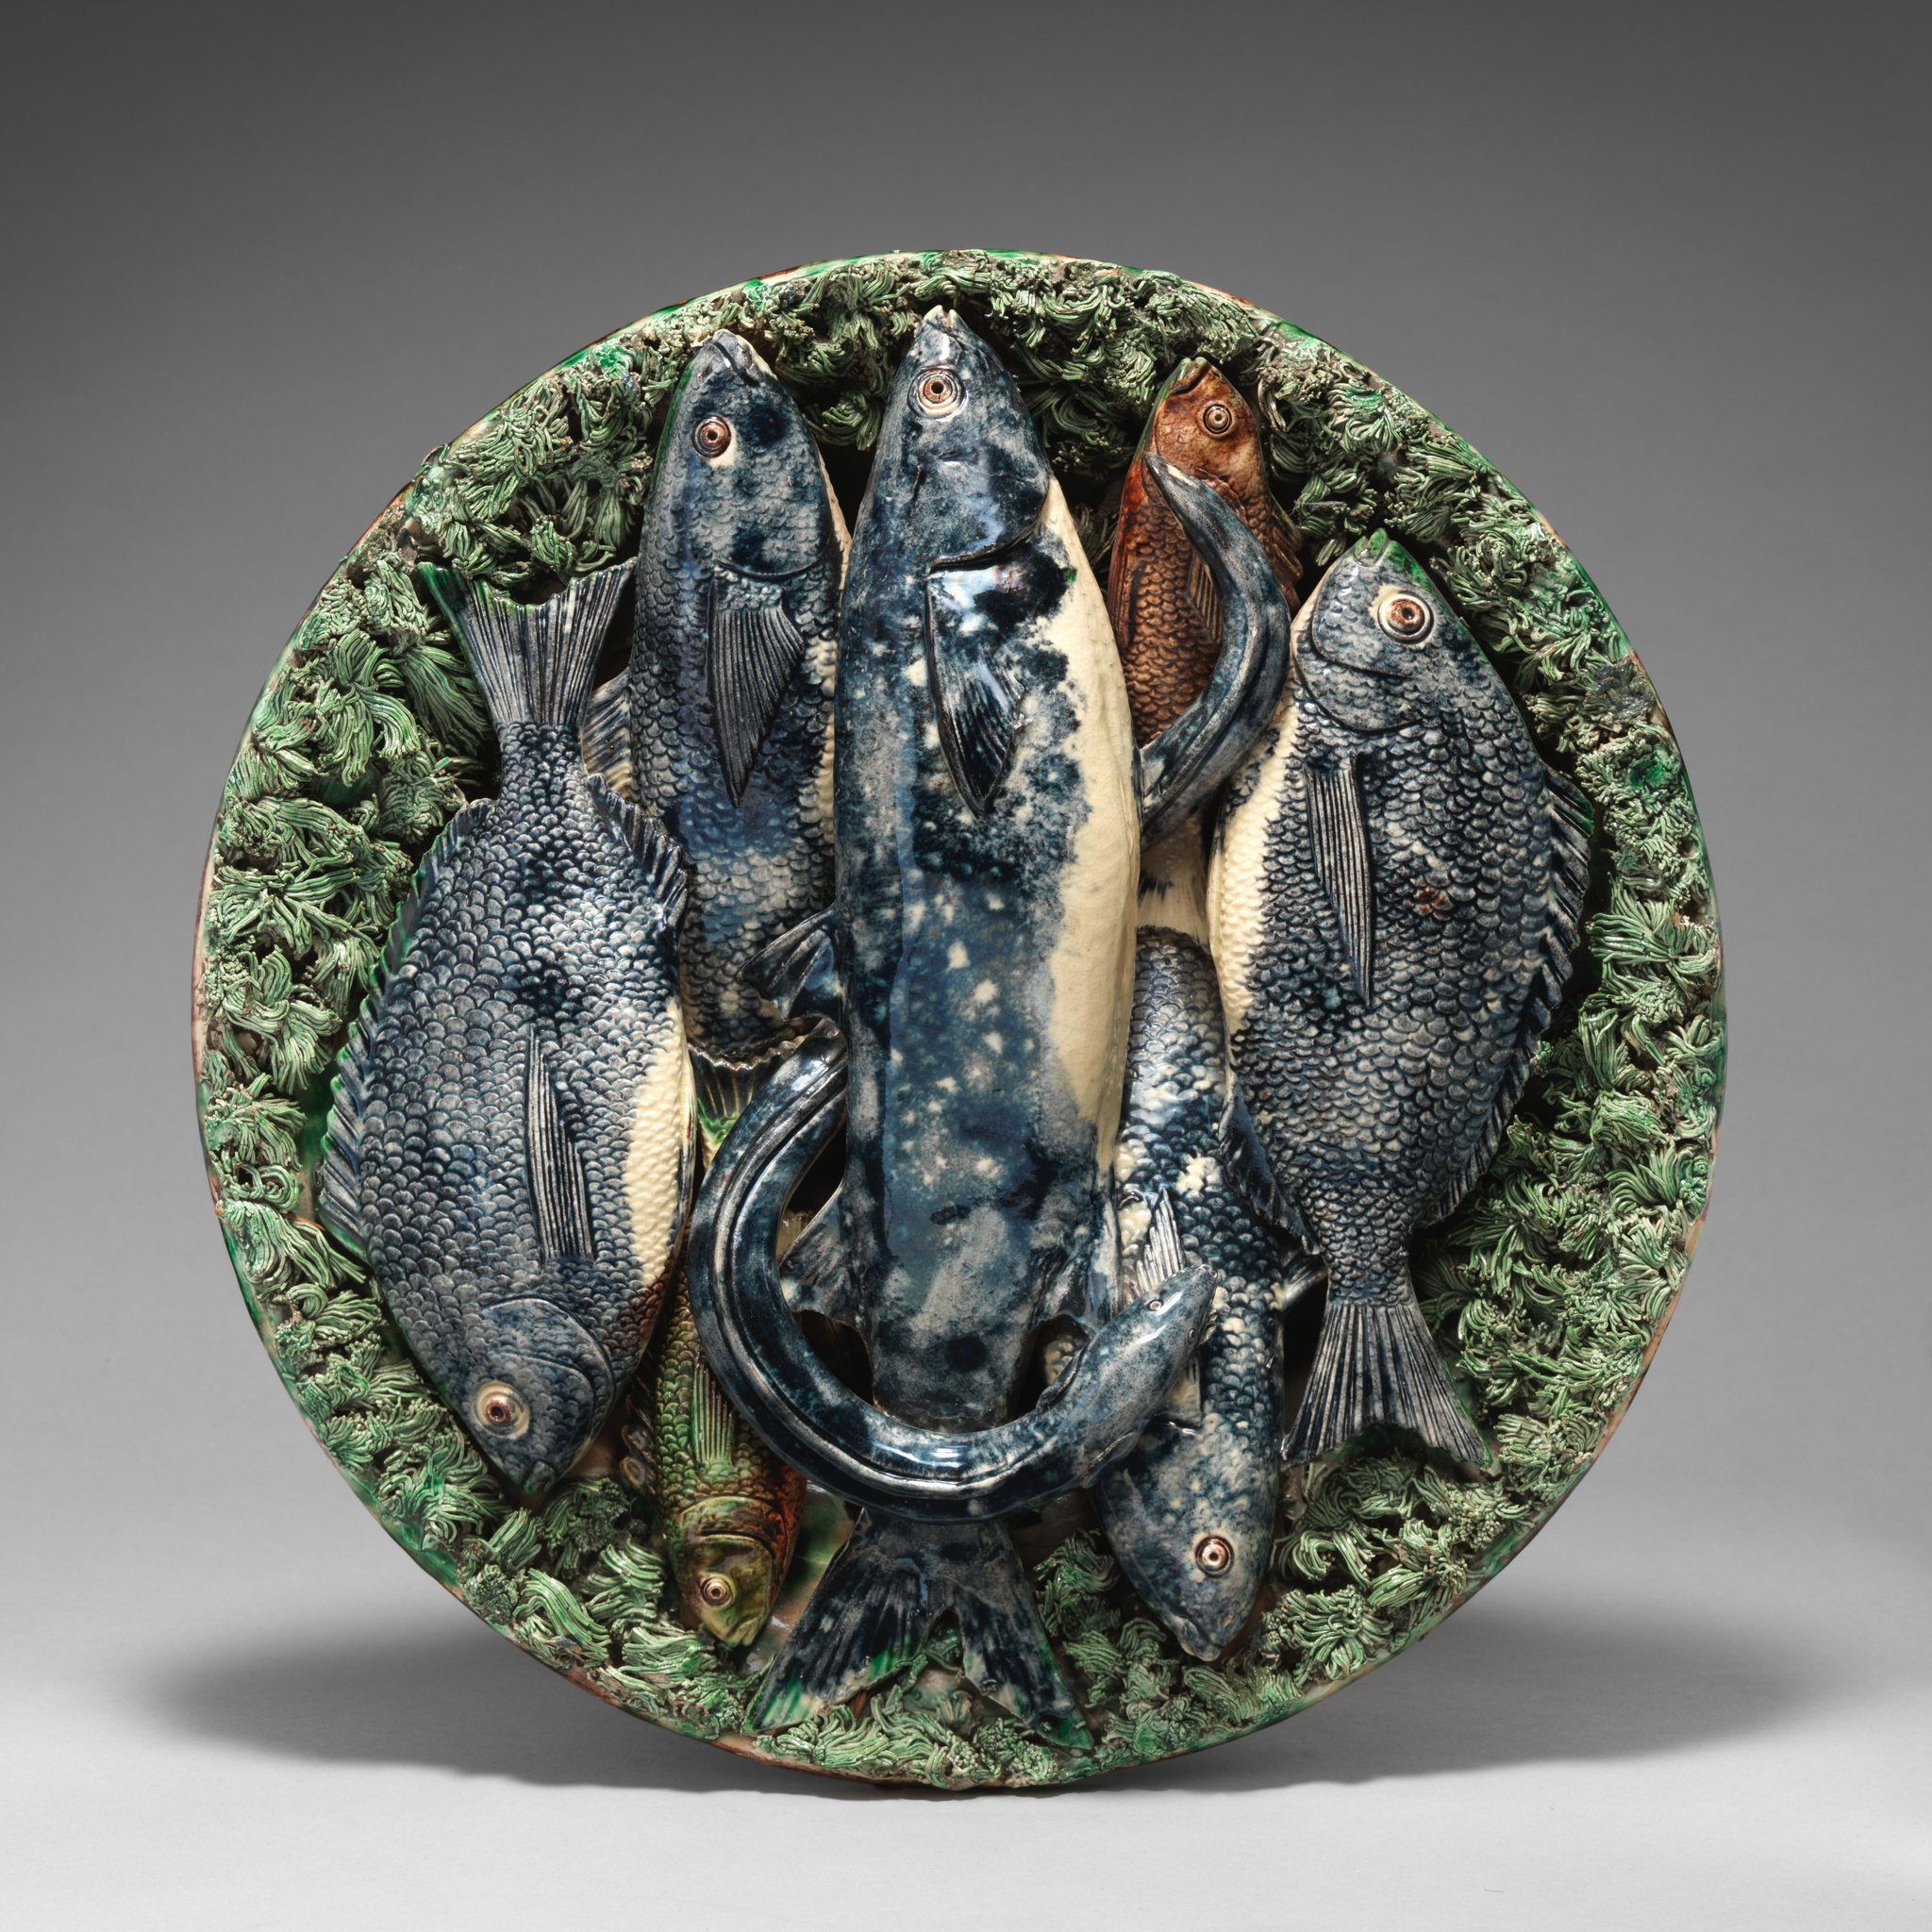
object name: plate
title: Round dish with moss and fish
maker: josé francisco de sousa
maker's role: maker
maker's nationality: portuguese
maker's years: 1860-1893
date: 1860-1893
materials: earthenware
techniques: glazing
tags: fish